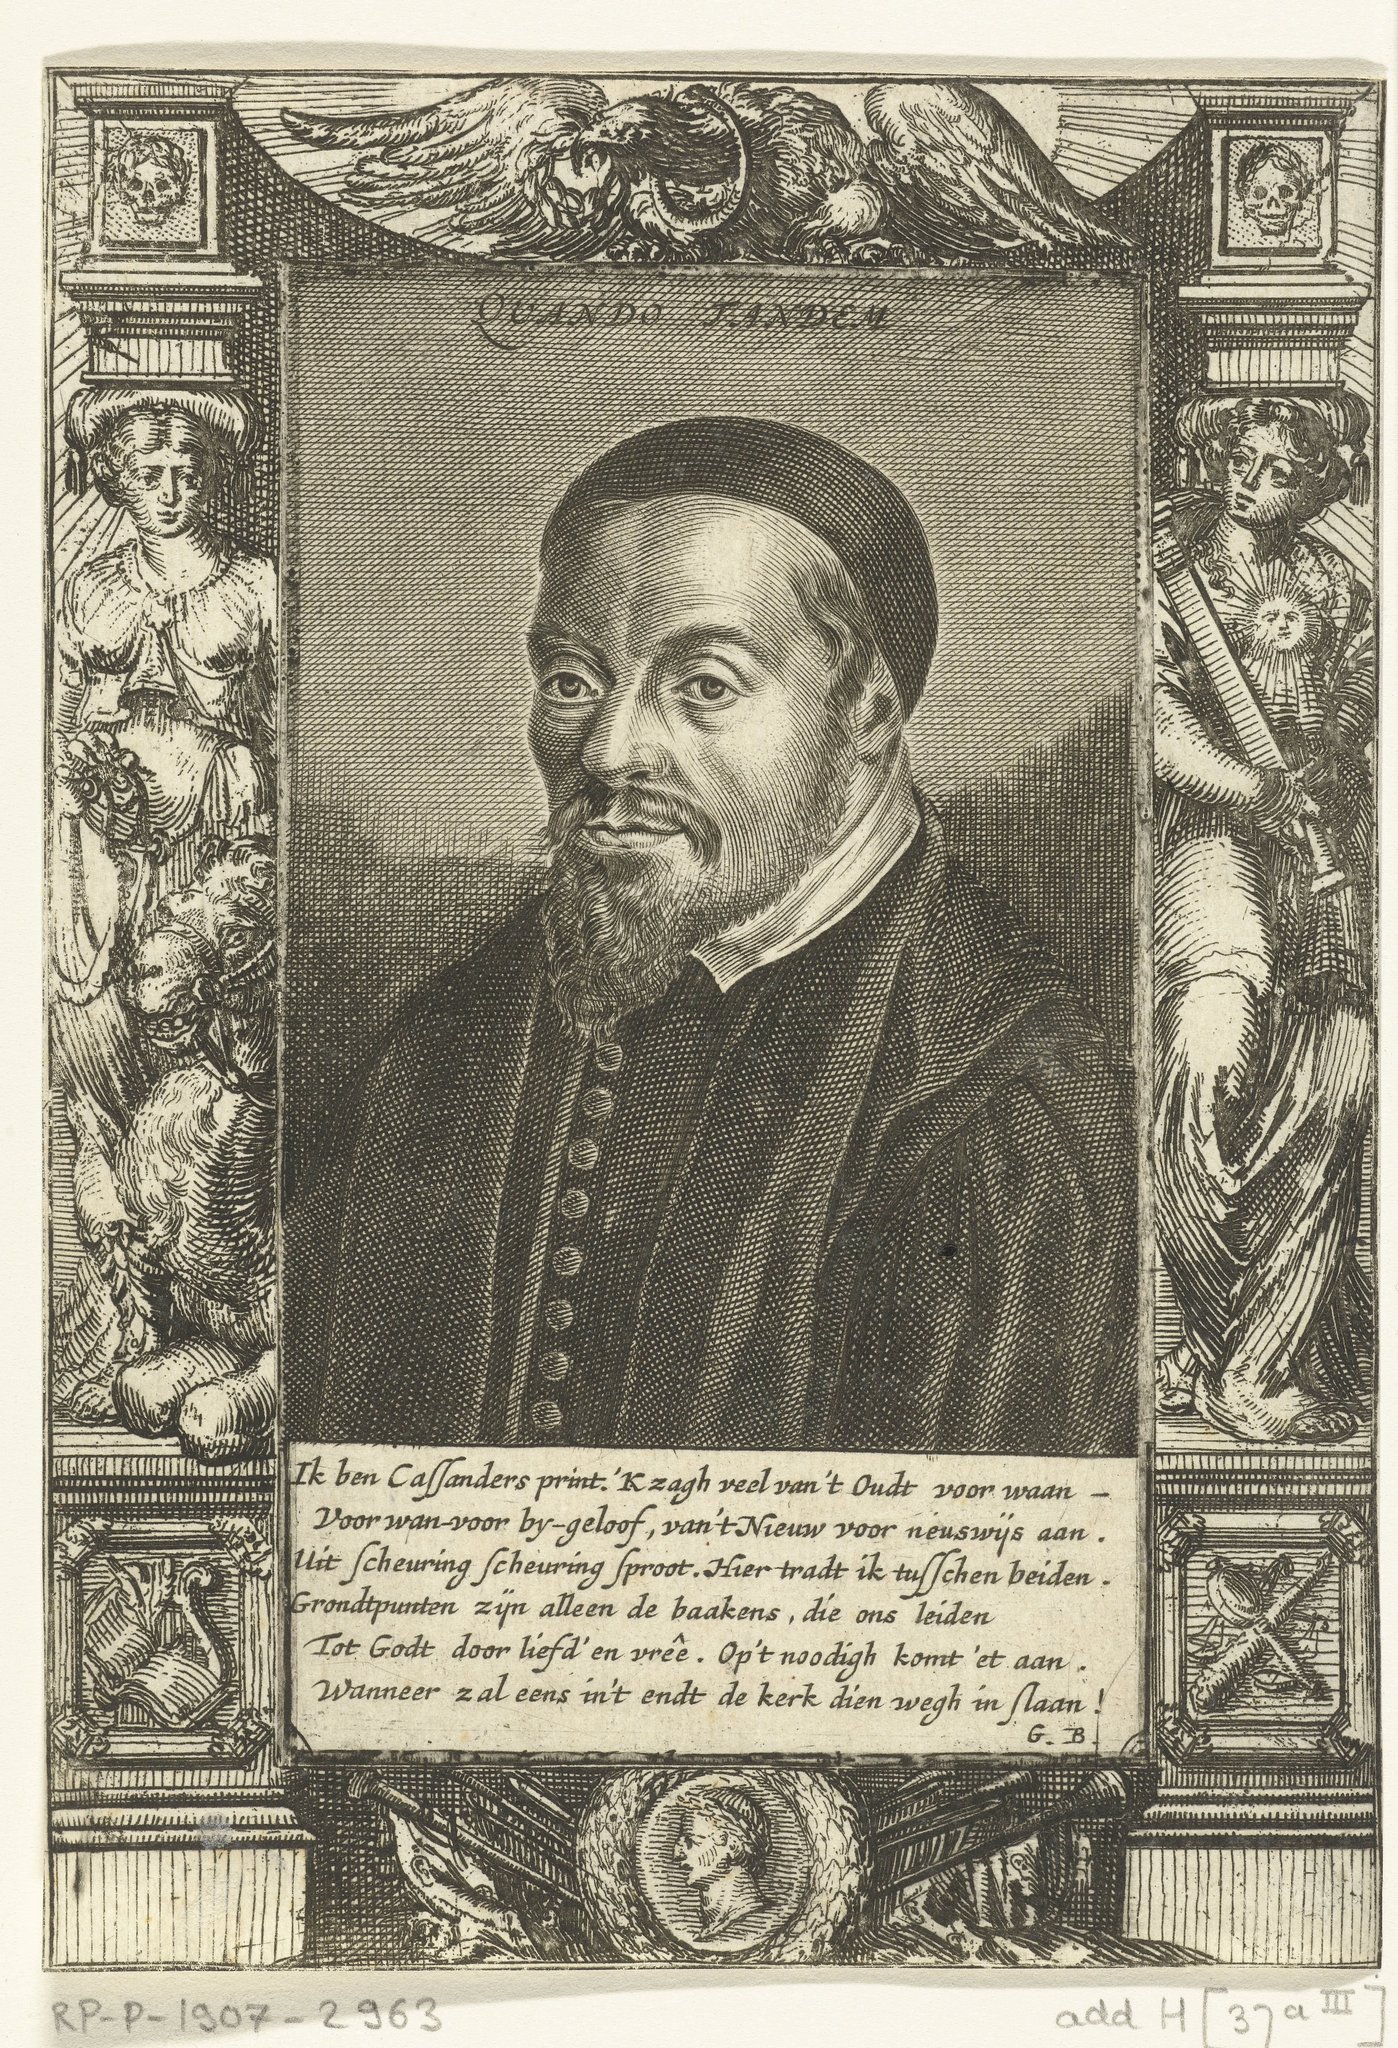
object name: book illustration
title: Portret van Georg Cassander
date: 1663-1707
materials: paper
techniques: engraving, etching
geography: netherlands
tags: cologne, historical persons, armorial bearing, heraldry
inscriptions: collector's mark: Lugt 2228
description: Borstbeeld van Georg Cassander, met motto: Quando tandem. Onder het portret een vers van zes regels in het Nederlands door Geeraert Brandt. Omlijsting met allegorische figuren en symbolen. Prent gedrukt van twee platen